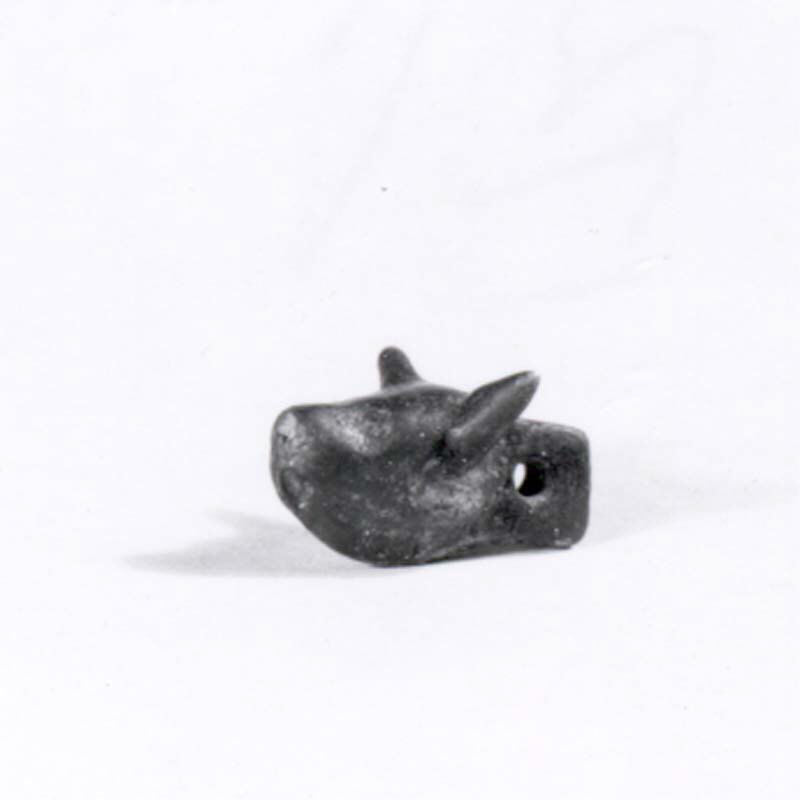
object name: ornament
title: Animal head ornament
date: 1000-1 BCE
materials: bronze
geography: transcaucasia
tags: animals